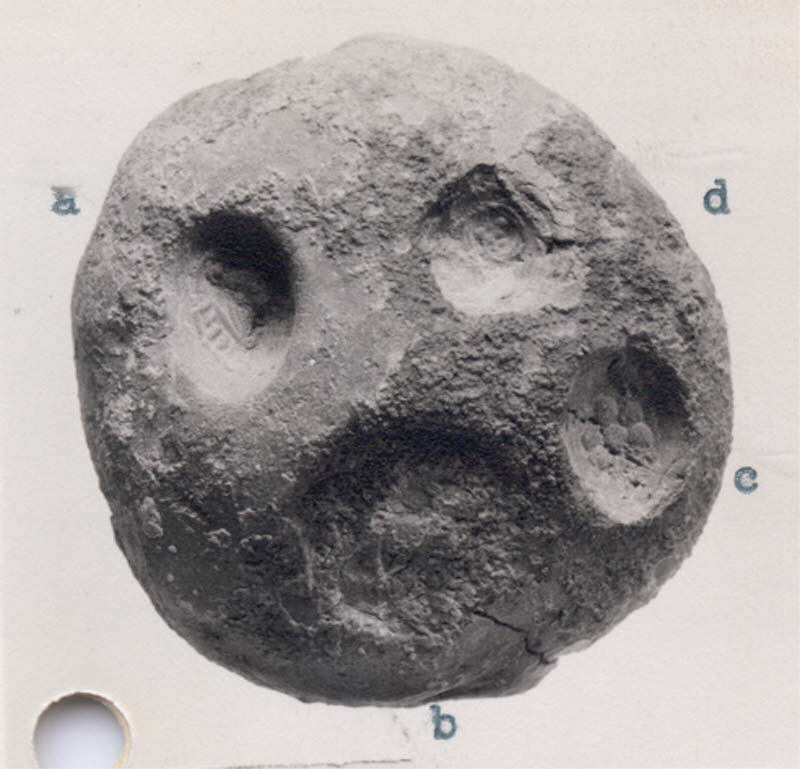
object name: sealing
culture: sasanian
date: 601-700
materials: clay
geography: iran